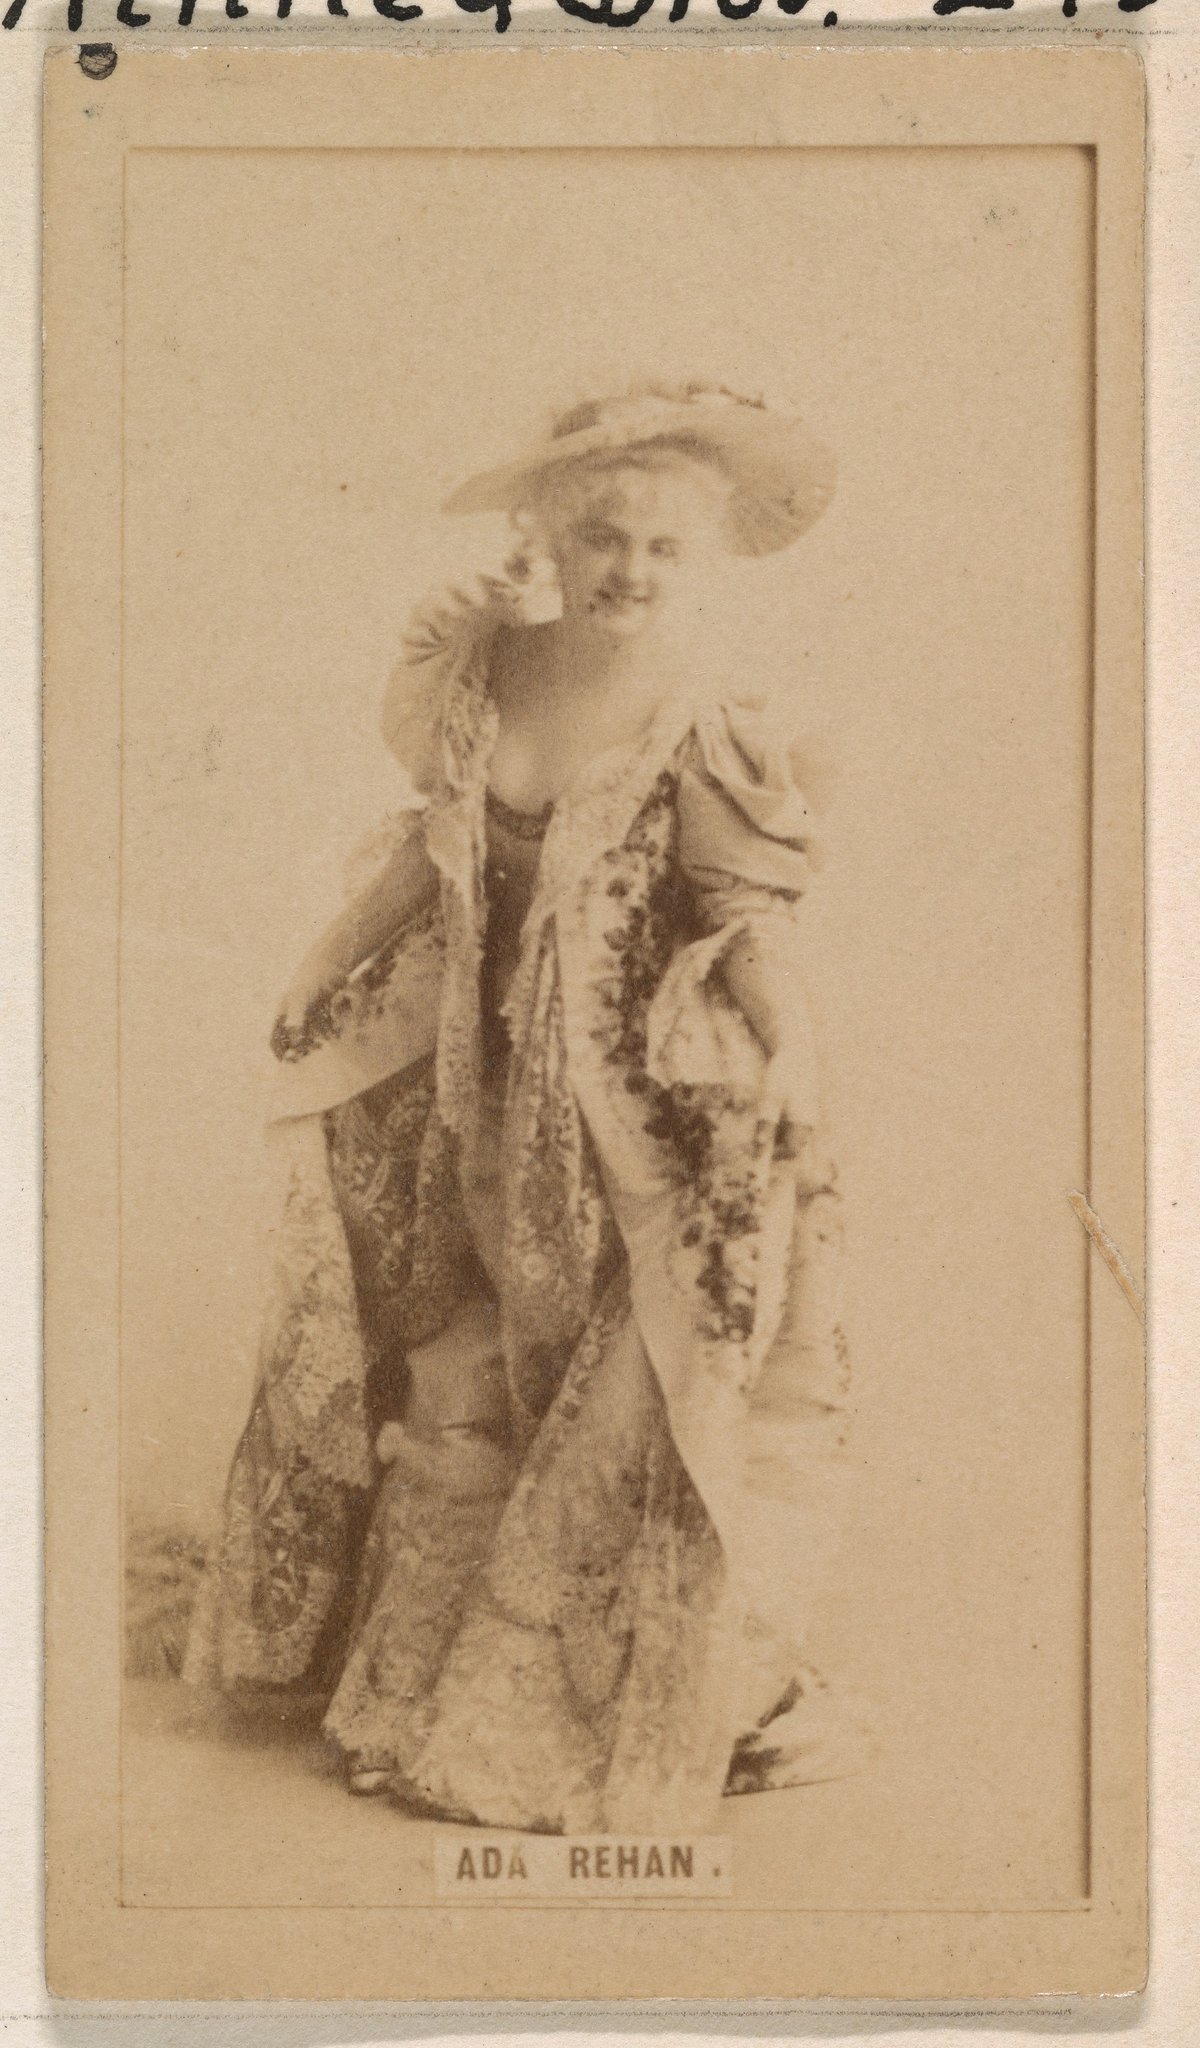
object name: photograph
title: Ada Rehan, from the Actresses series (N245) issued by Kinney Brothers to promote Sweet Caporal Cigarettes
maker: kinney brothers tobacco company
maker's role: publisher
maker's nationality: american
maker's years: 1869-2011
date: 1890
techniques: albumen silver print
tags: portraits,women,actresses